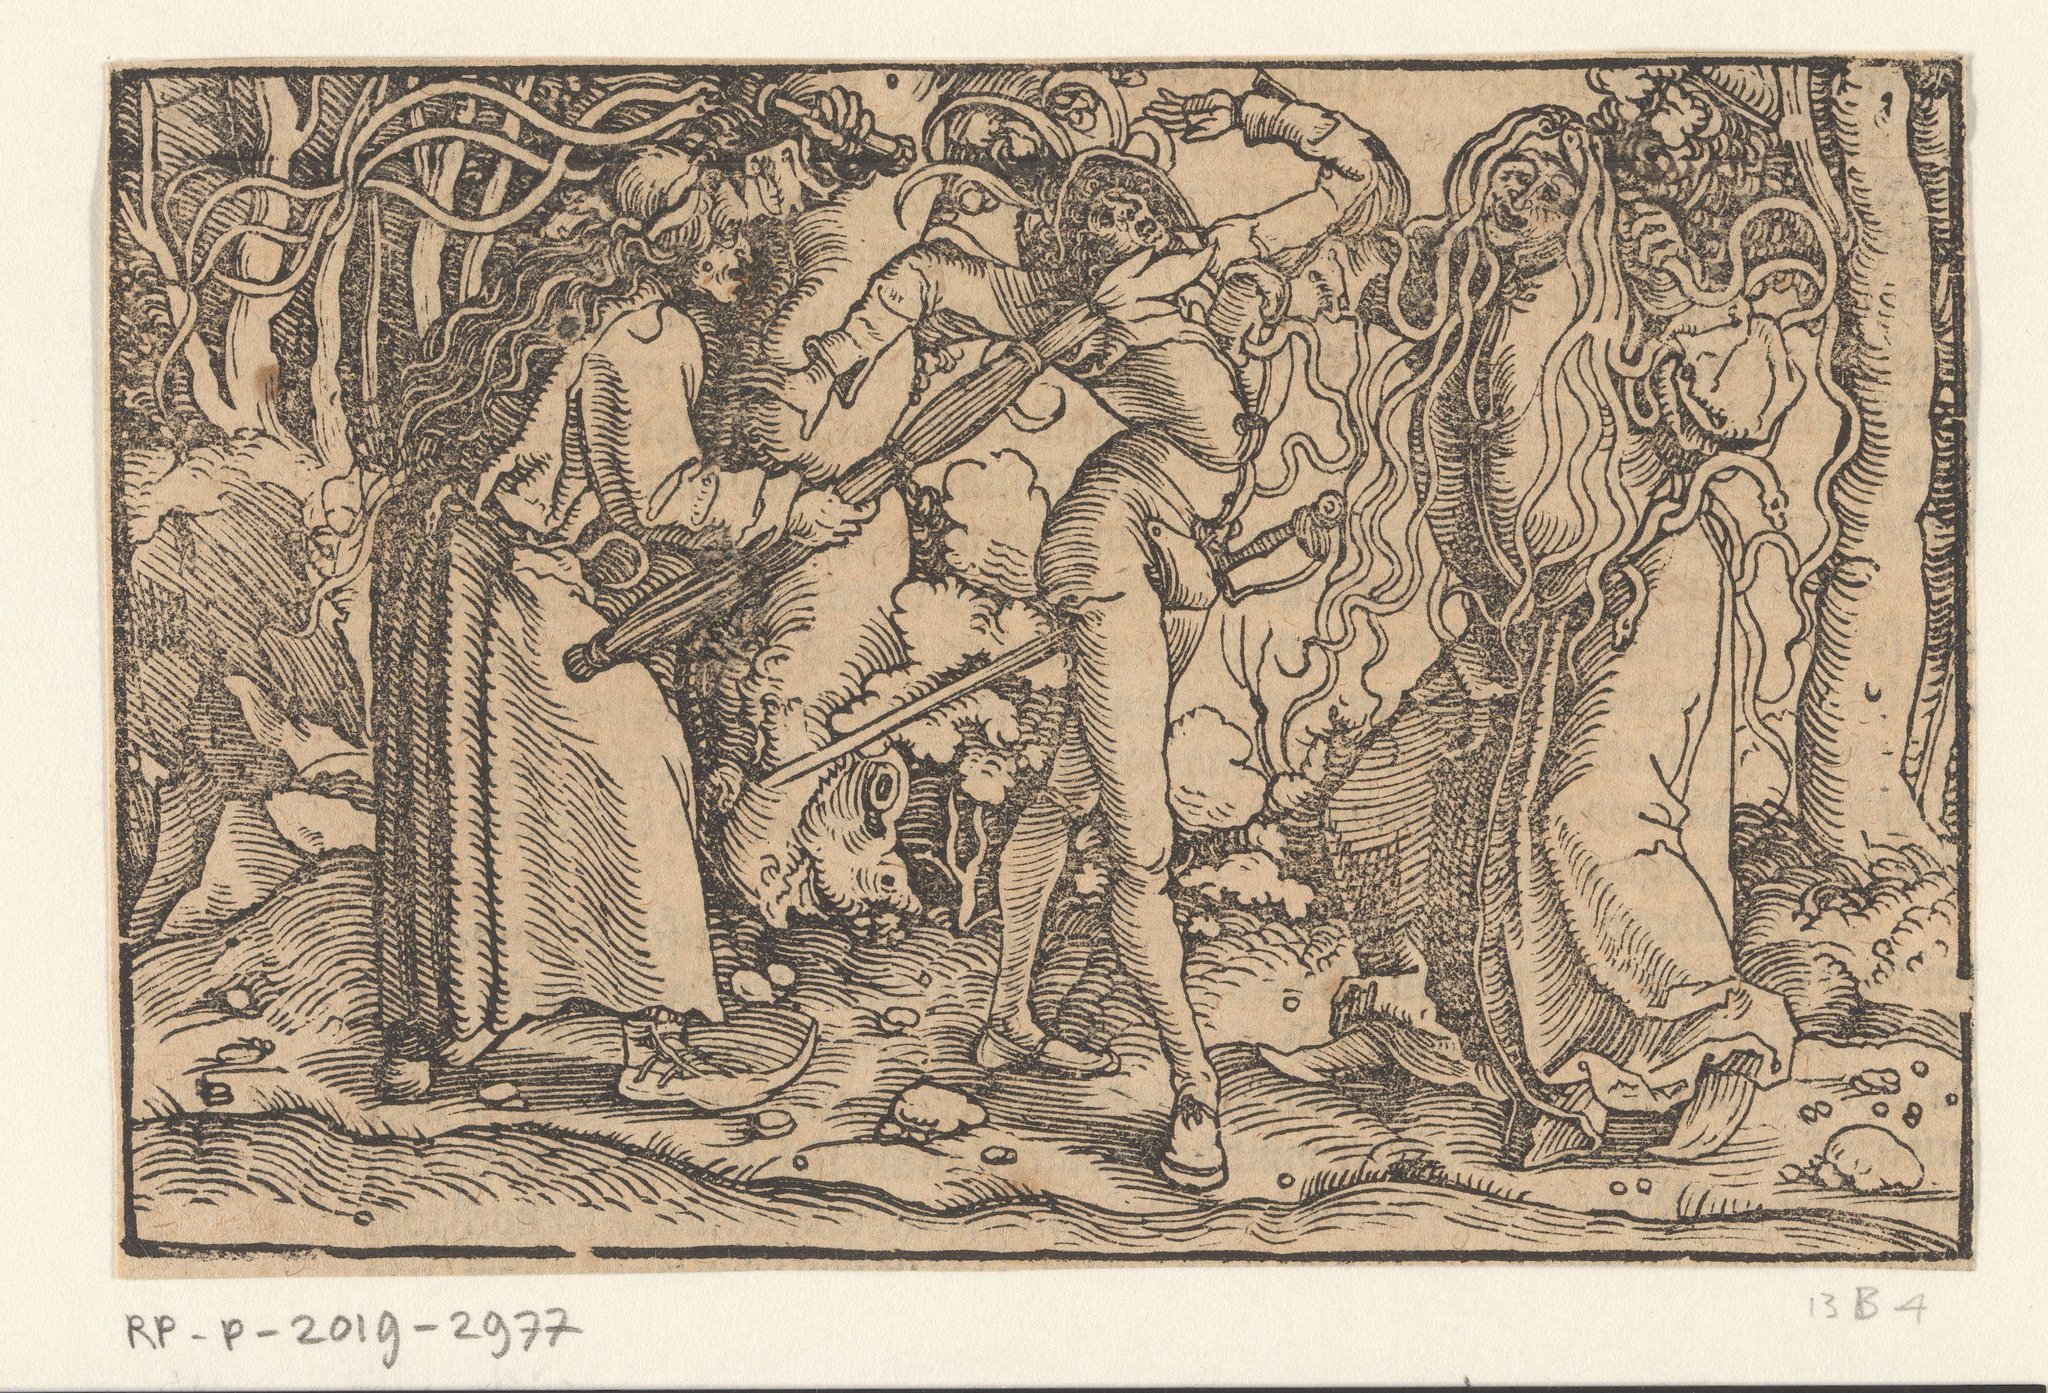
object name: print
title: Jongeman bij twee gorgonen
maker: Anonymous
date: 1500-1599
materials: paper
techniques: letterpress printing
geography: germany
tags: gorgons, witch(es), sorcerer(s) at work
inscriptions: collector's mark: Lugt 2228